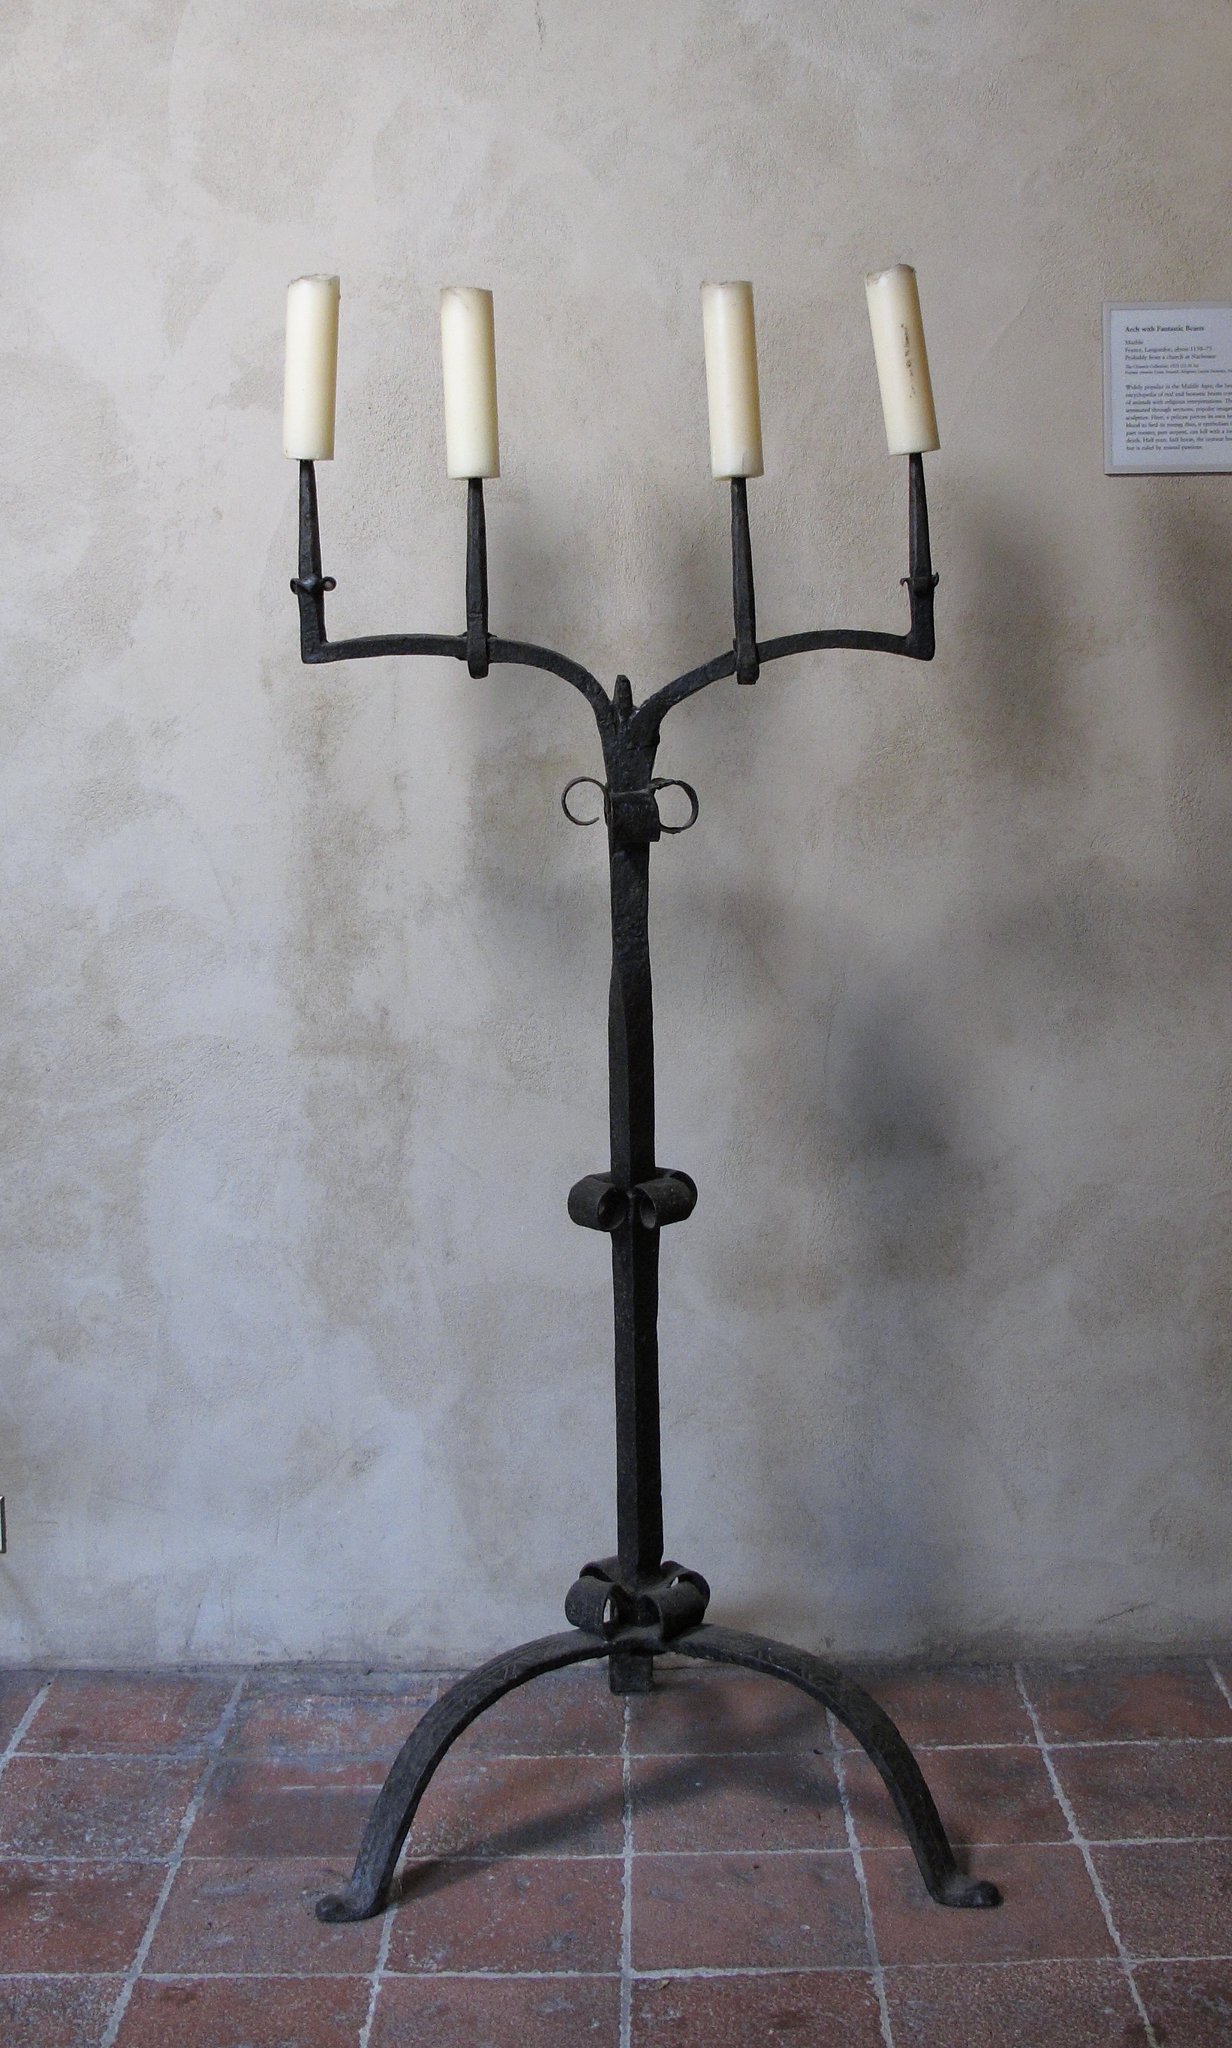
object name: candelabrum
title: Candelabra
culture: european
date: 1401-1600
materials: iron